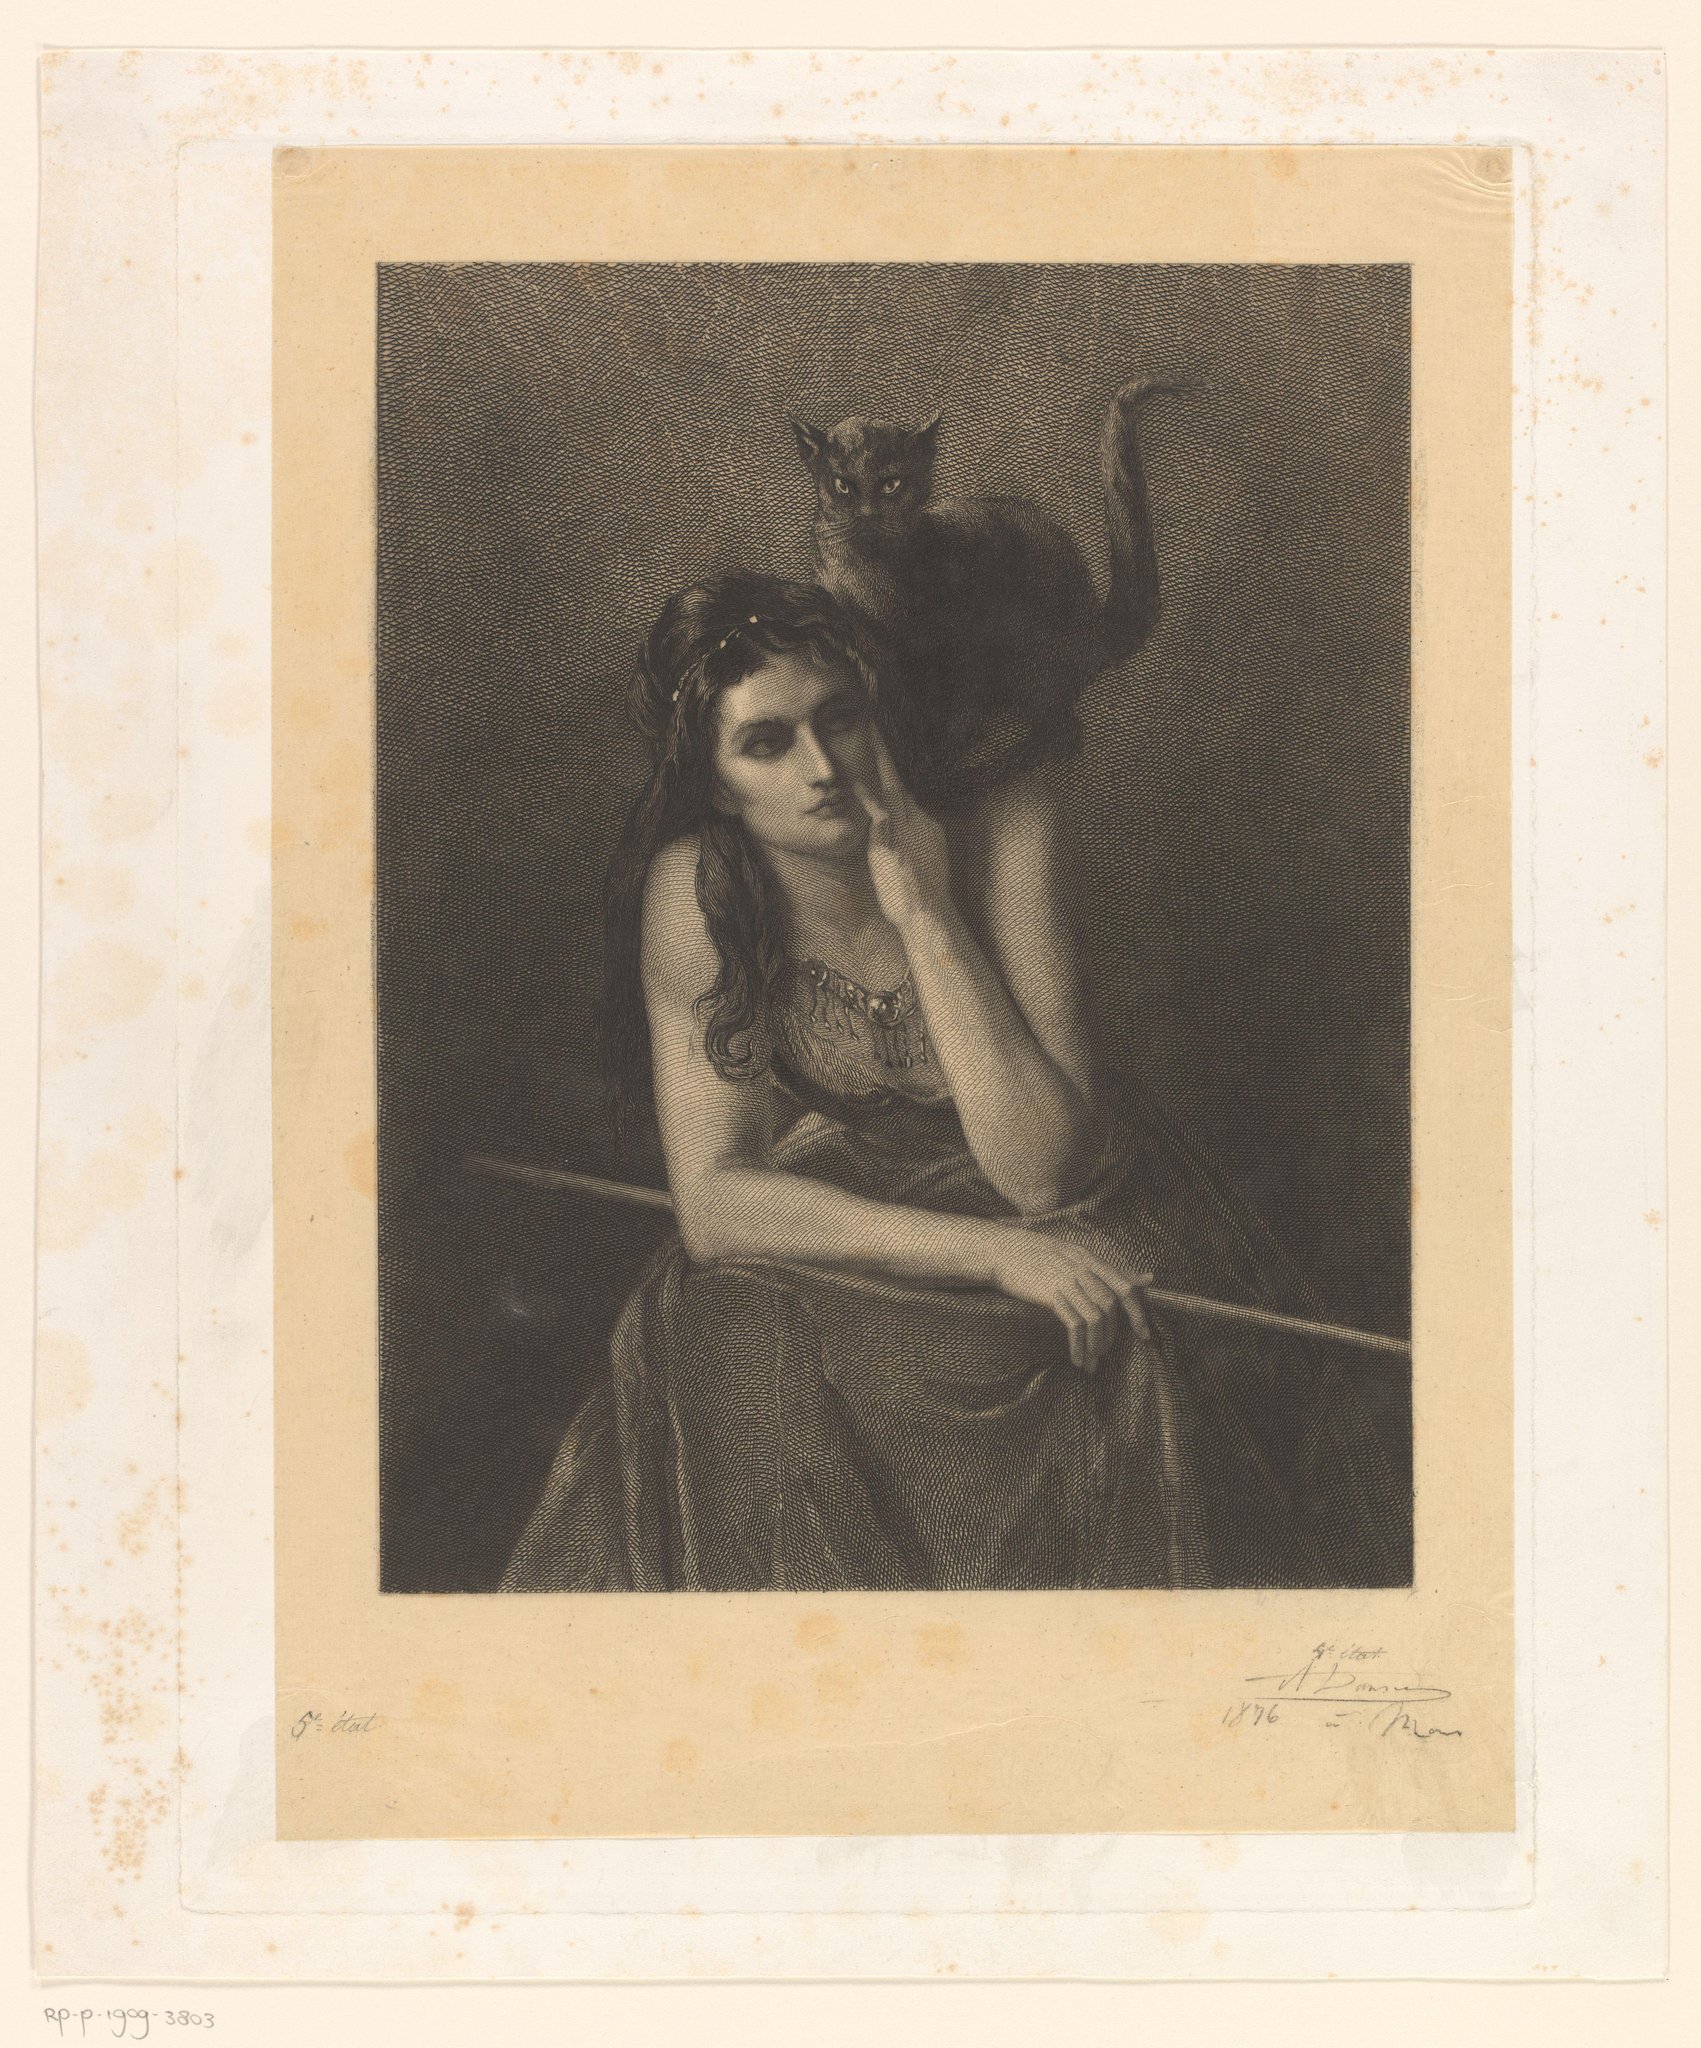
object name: print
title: Jonge vrouw met een kat op de schouder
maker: auguste danse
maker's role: print maker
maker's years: 1829-1929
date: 1876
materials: paper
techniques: drypoint, etching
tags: adolescent, young woman, maiden, cat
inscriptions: annotation: ‘4e état’, collector's mark: Lugt 2228, annotation: ‘5e état’